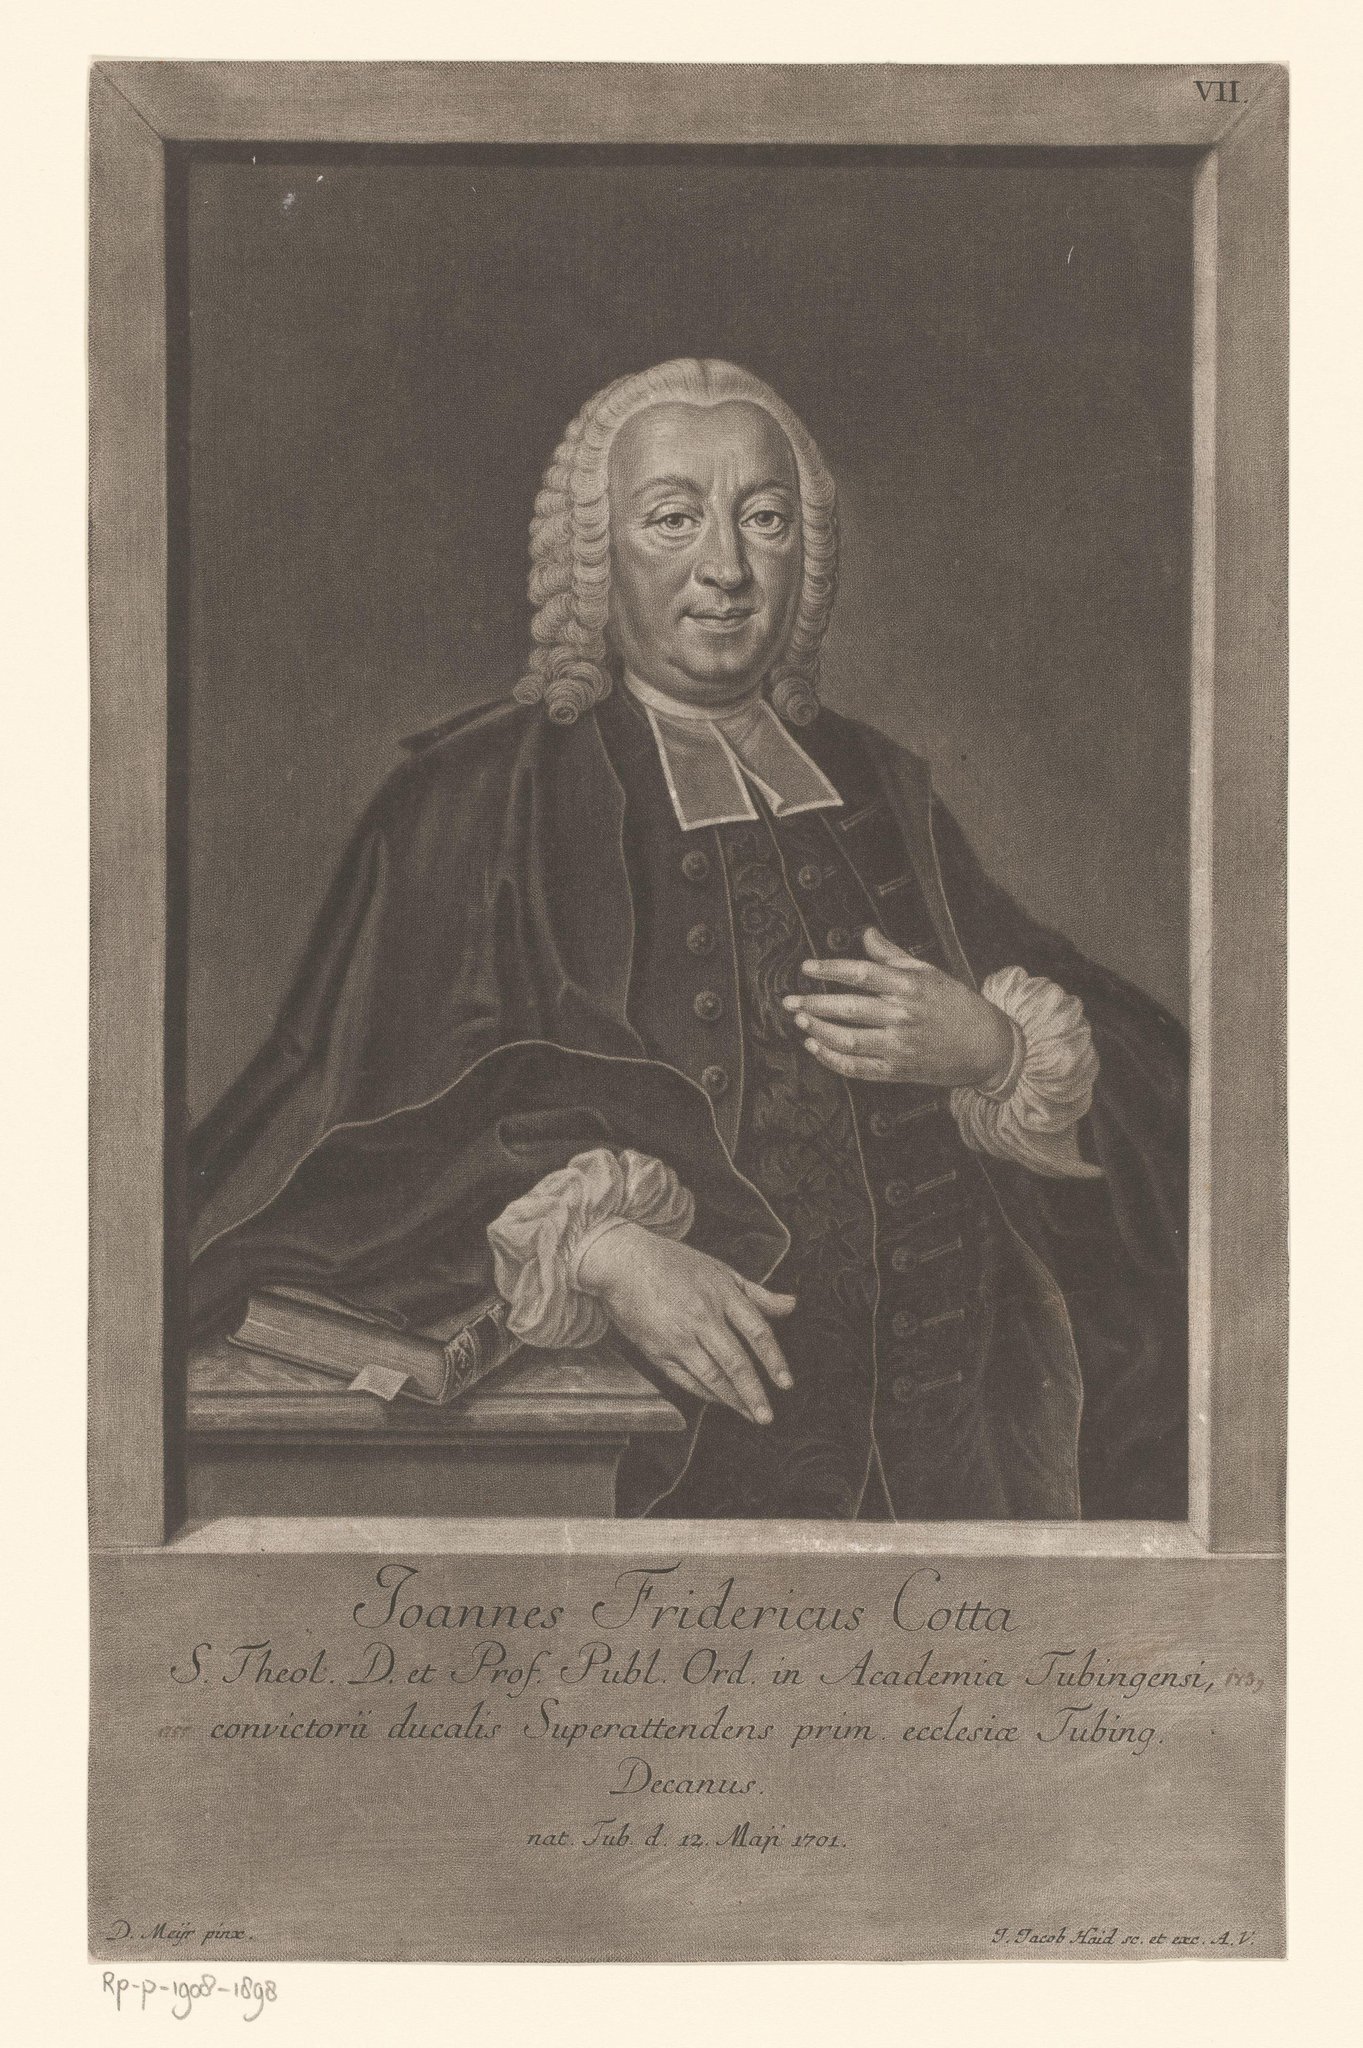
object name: print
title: Portret van Johann Friedrich Cotta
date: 1757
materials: paper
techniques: mezzotint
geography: augsburg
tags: theologian, historical persons, book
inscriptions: collector's mark: Lugt 2228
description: Prent gebruikt voor: Haid, Johann Jacob. Neue Sammlung von Bildnissen gelehrter (...) noch lebender Männer. Augsburg: Johann Jacob Haid, 1757.